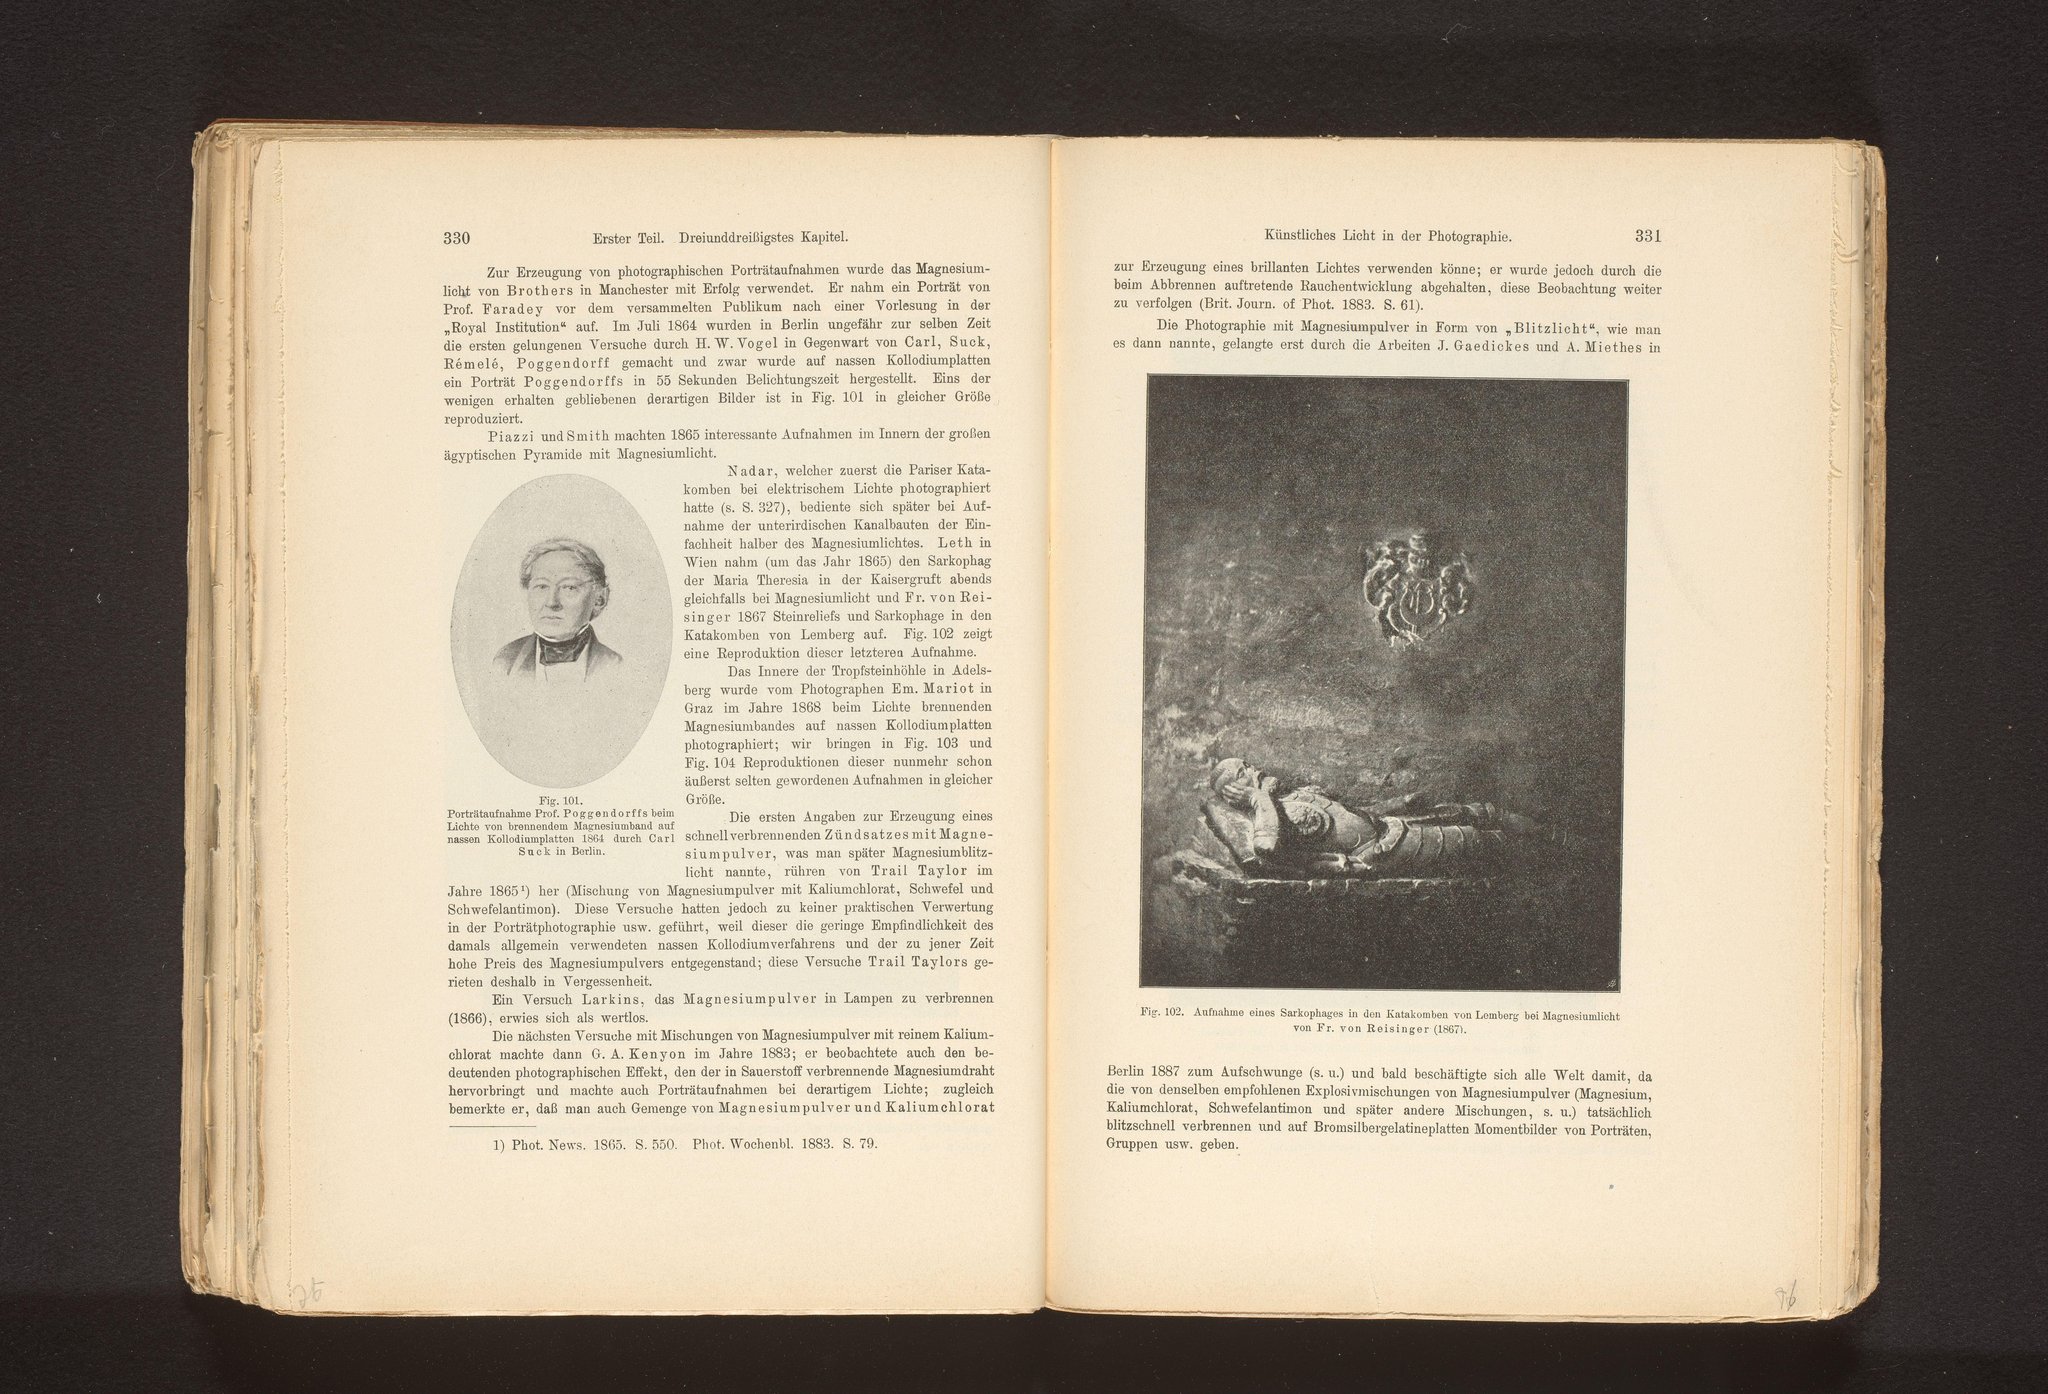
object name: page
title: Porträtaufnahme Prof. Poggendorffs beim Lichte von brennendem Magnesiumband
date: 1900-1905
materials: paper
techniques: autotype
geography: berlin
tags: physicist, old man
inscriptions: number: ‘Fig. 101.’